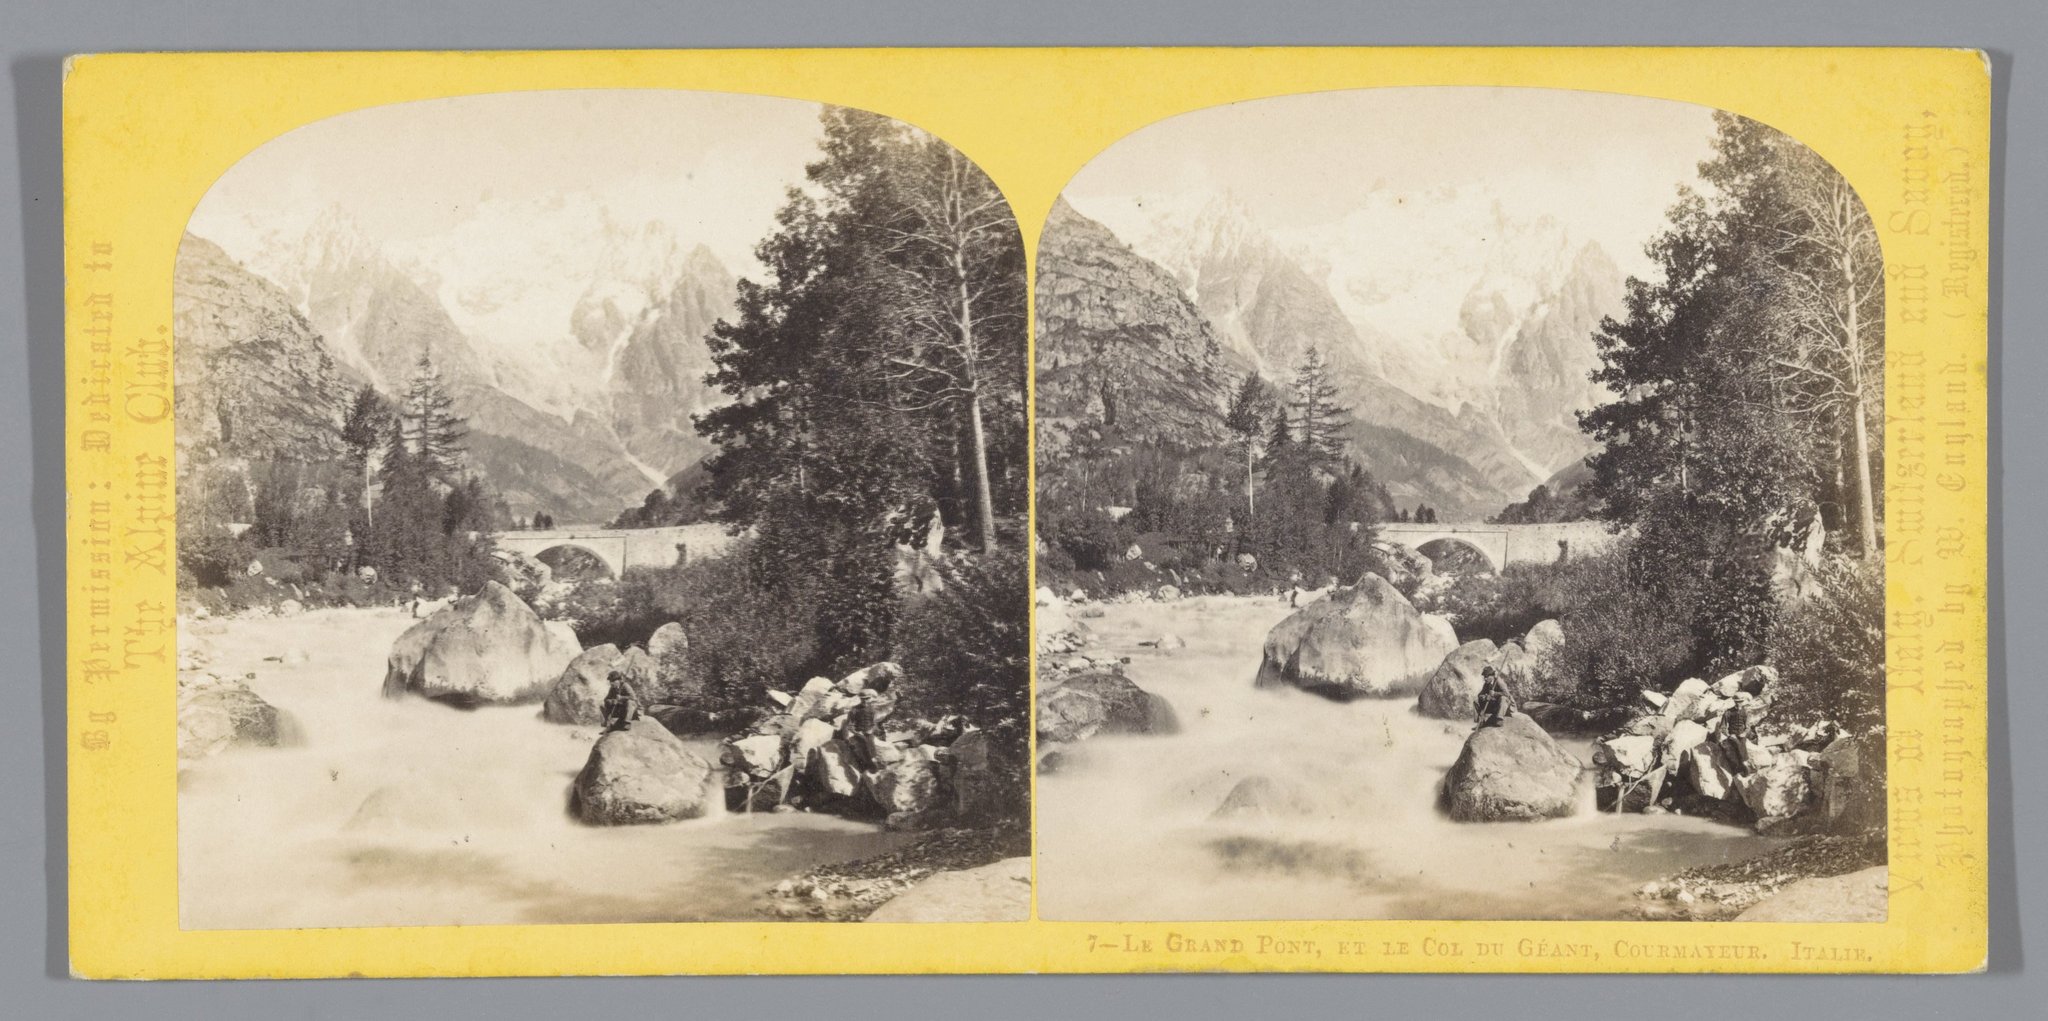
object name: stereograph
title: Views of Italy, Switzerland and Savoy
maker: william england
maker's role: fotograaf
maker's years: 1816-1896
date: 1850-1880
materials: cardboard, photographic support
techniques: albumen print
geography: courmayeur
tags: mountain-range, snow peaks, courmayeur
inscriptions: inscription: ‘By Permission: Dedicated to The Alpine Club’, inscription: ‘N7. Le grand pont et le col du Géant Courmayeur Italie’, number: ‘7’